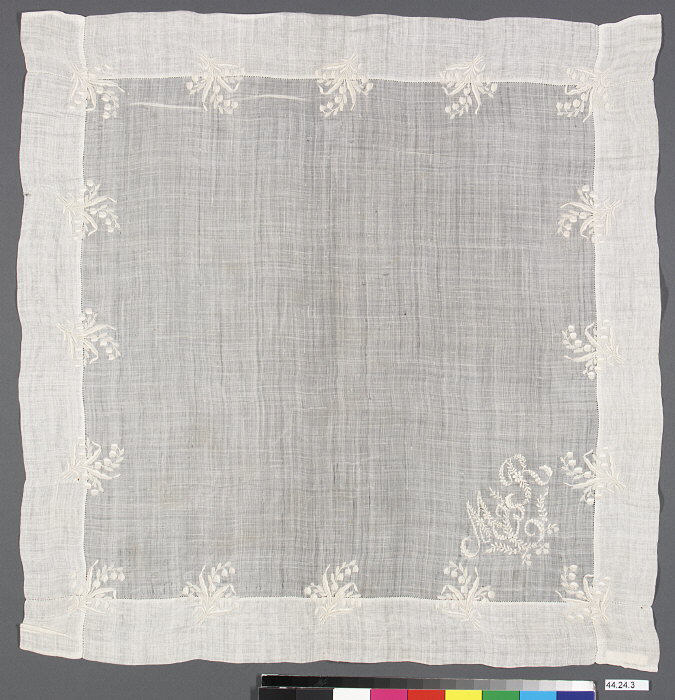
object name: handkerchief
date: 1801-1900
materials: linen